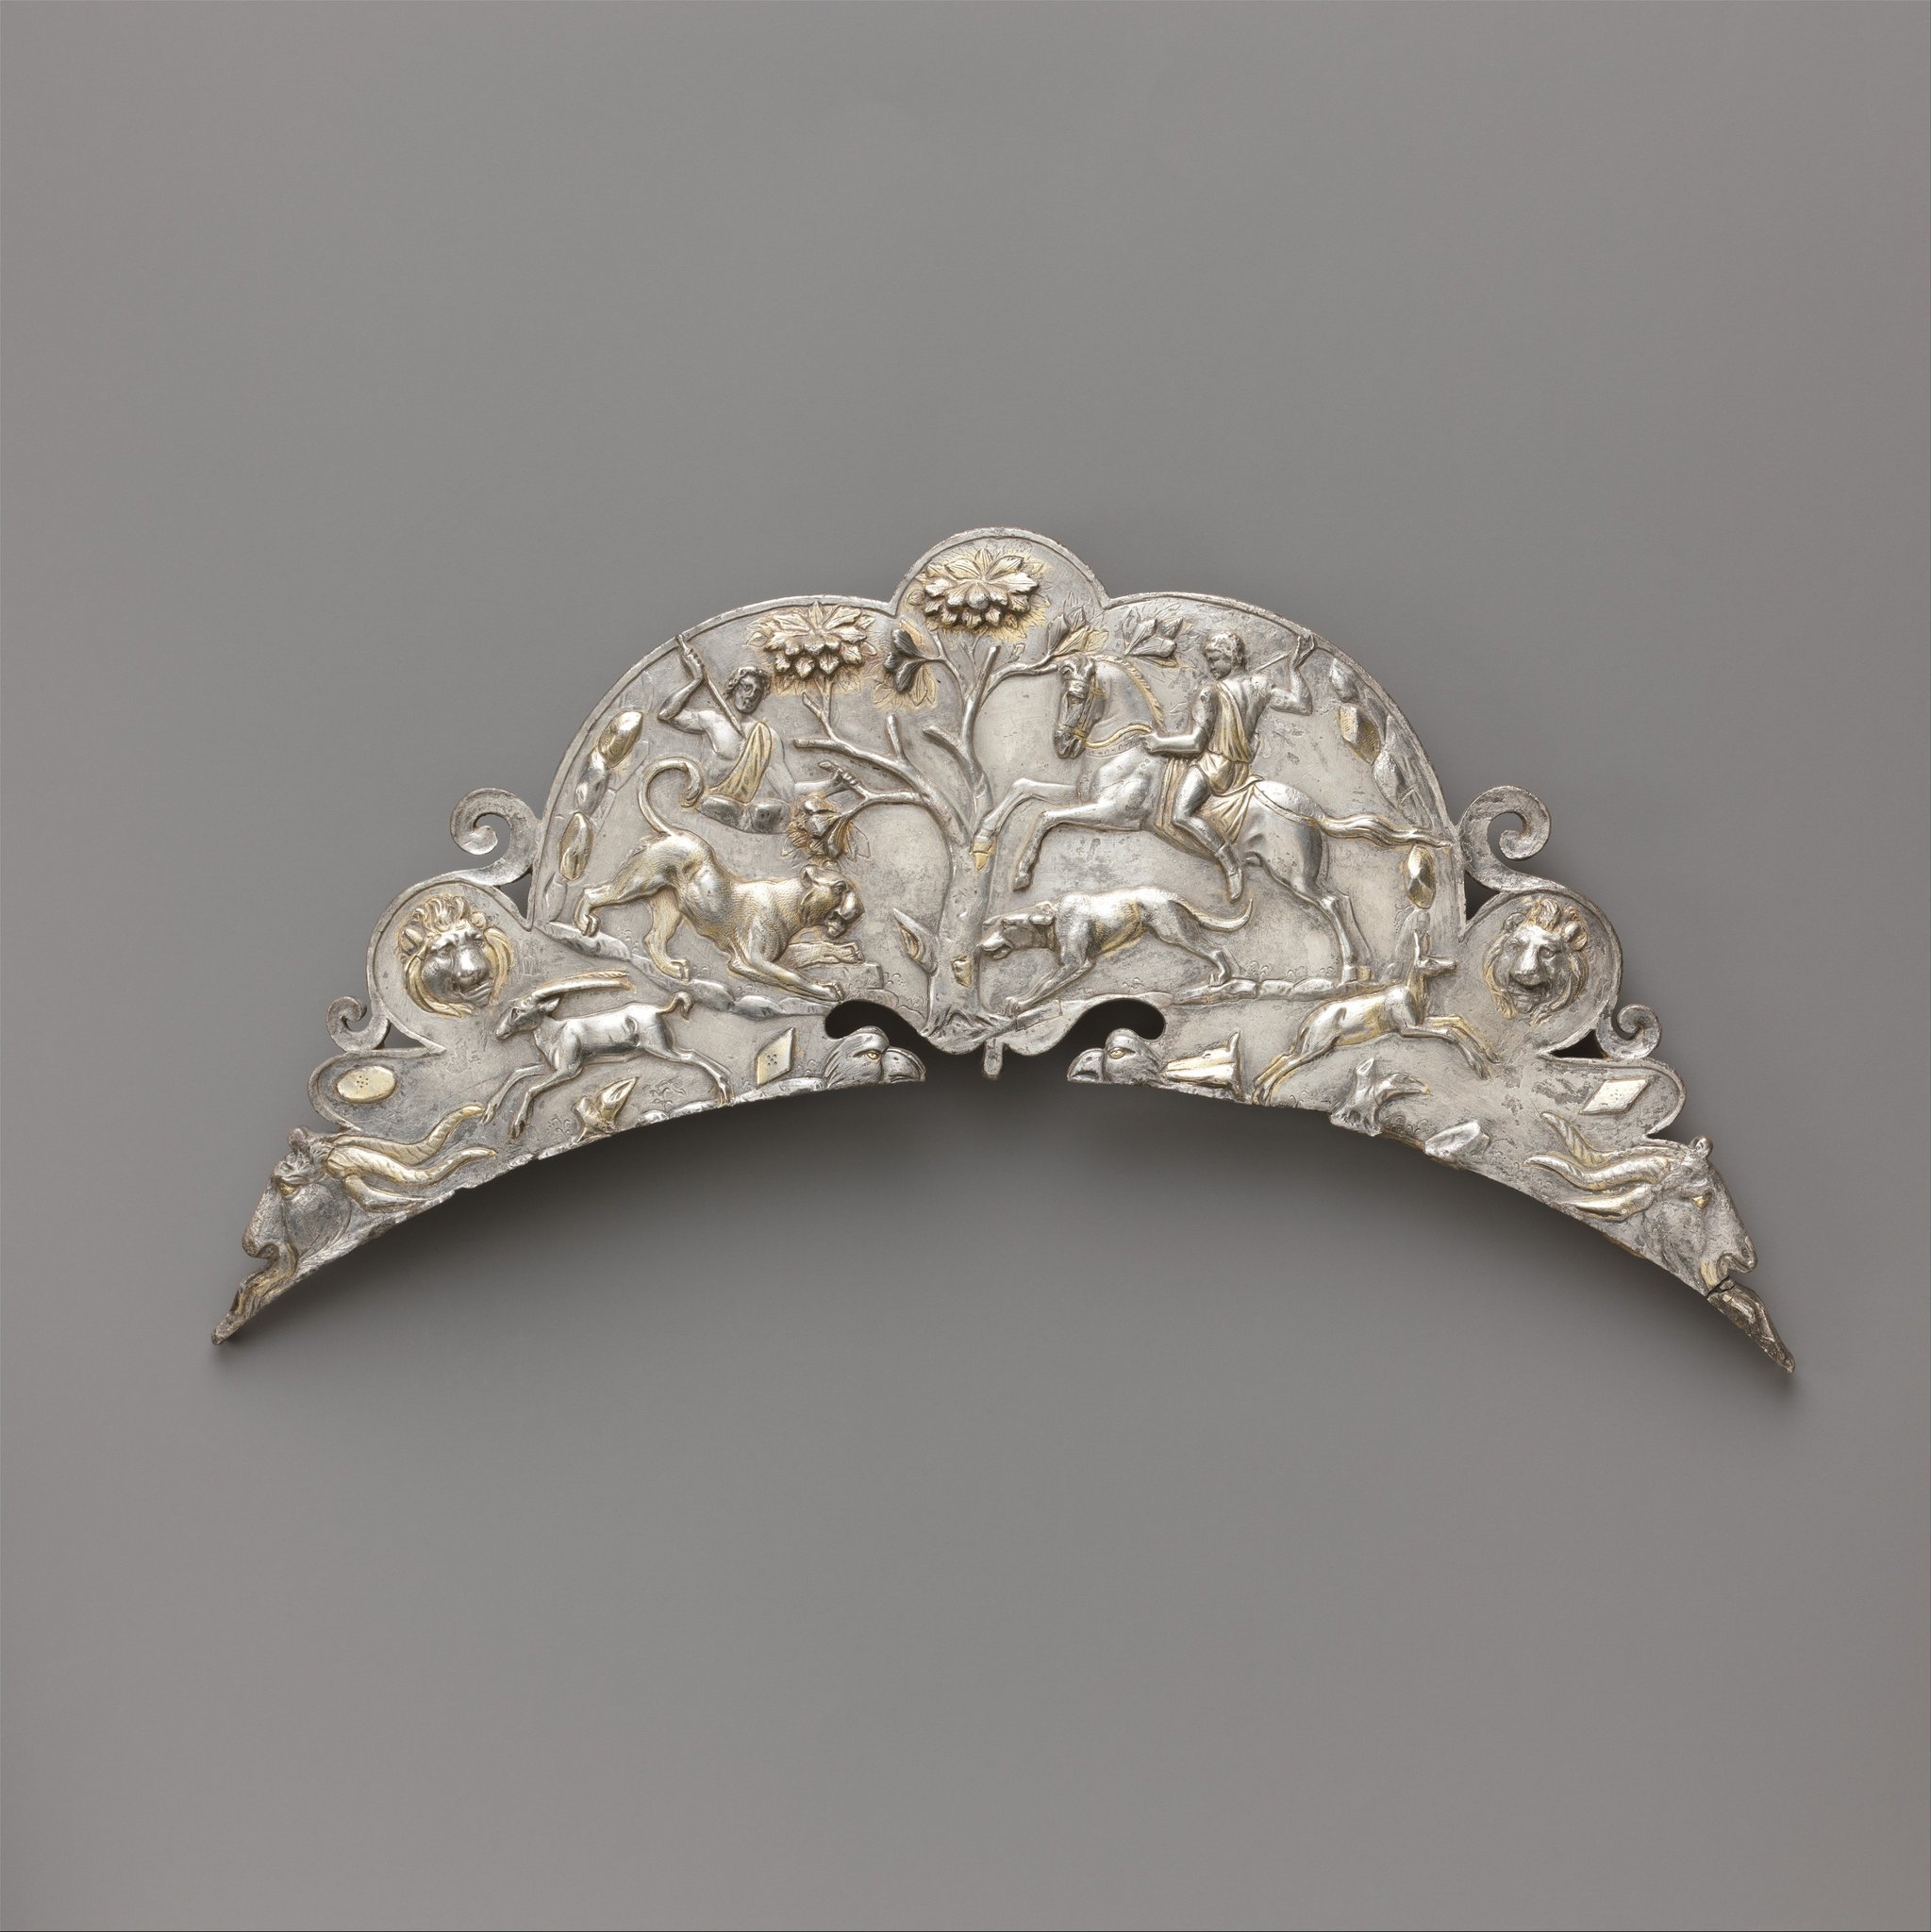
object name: handle of a dish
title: Silver handle of a large dish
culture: roman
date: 101-233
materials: gold, silver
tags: hunting,dogs,goats,horses,lions,trees